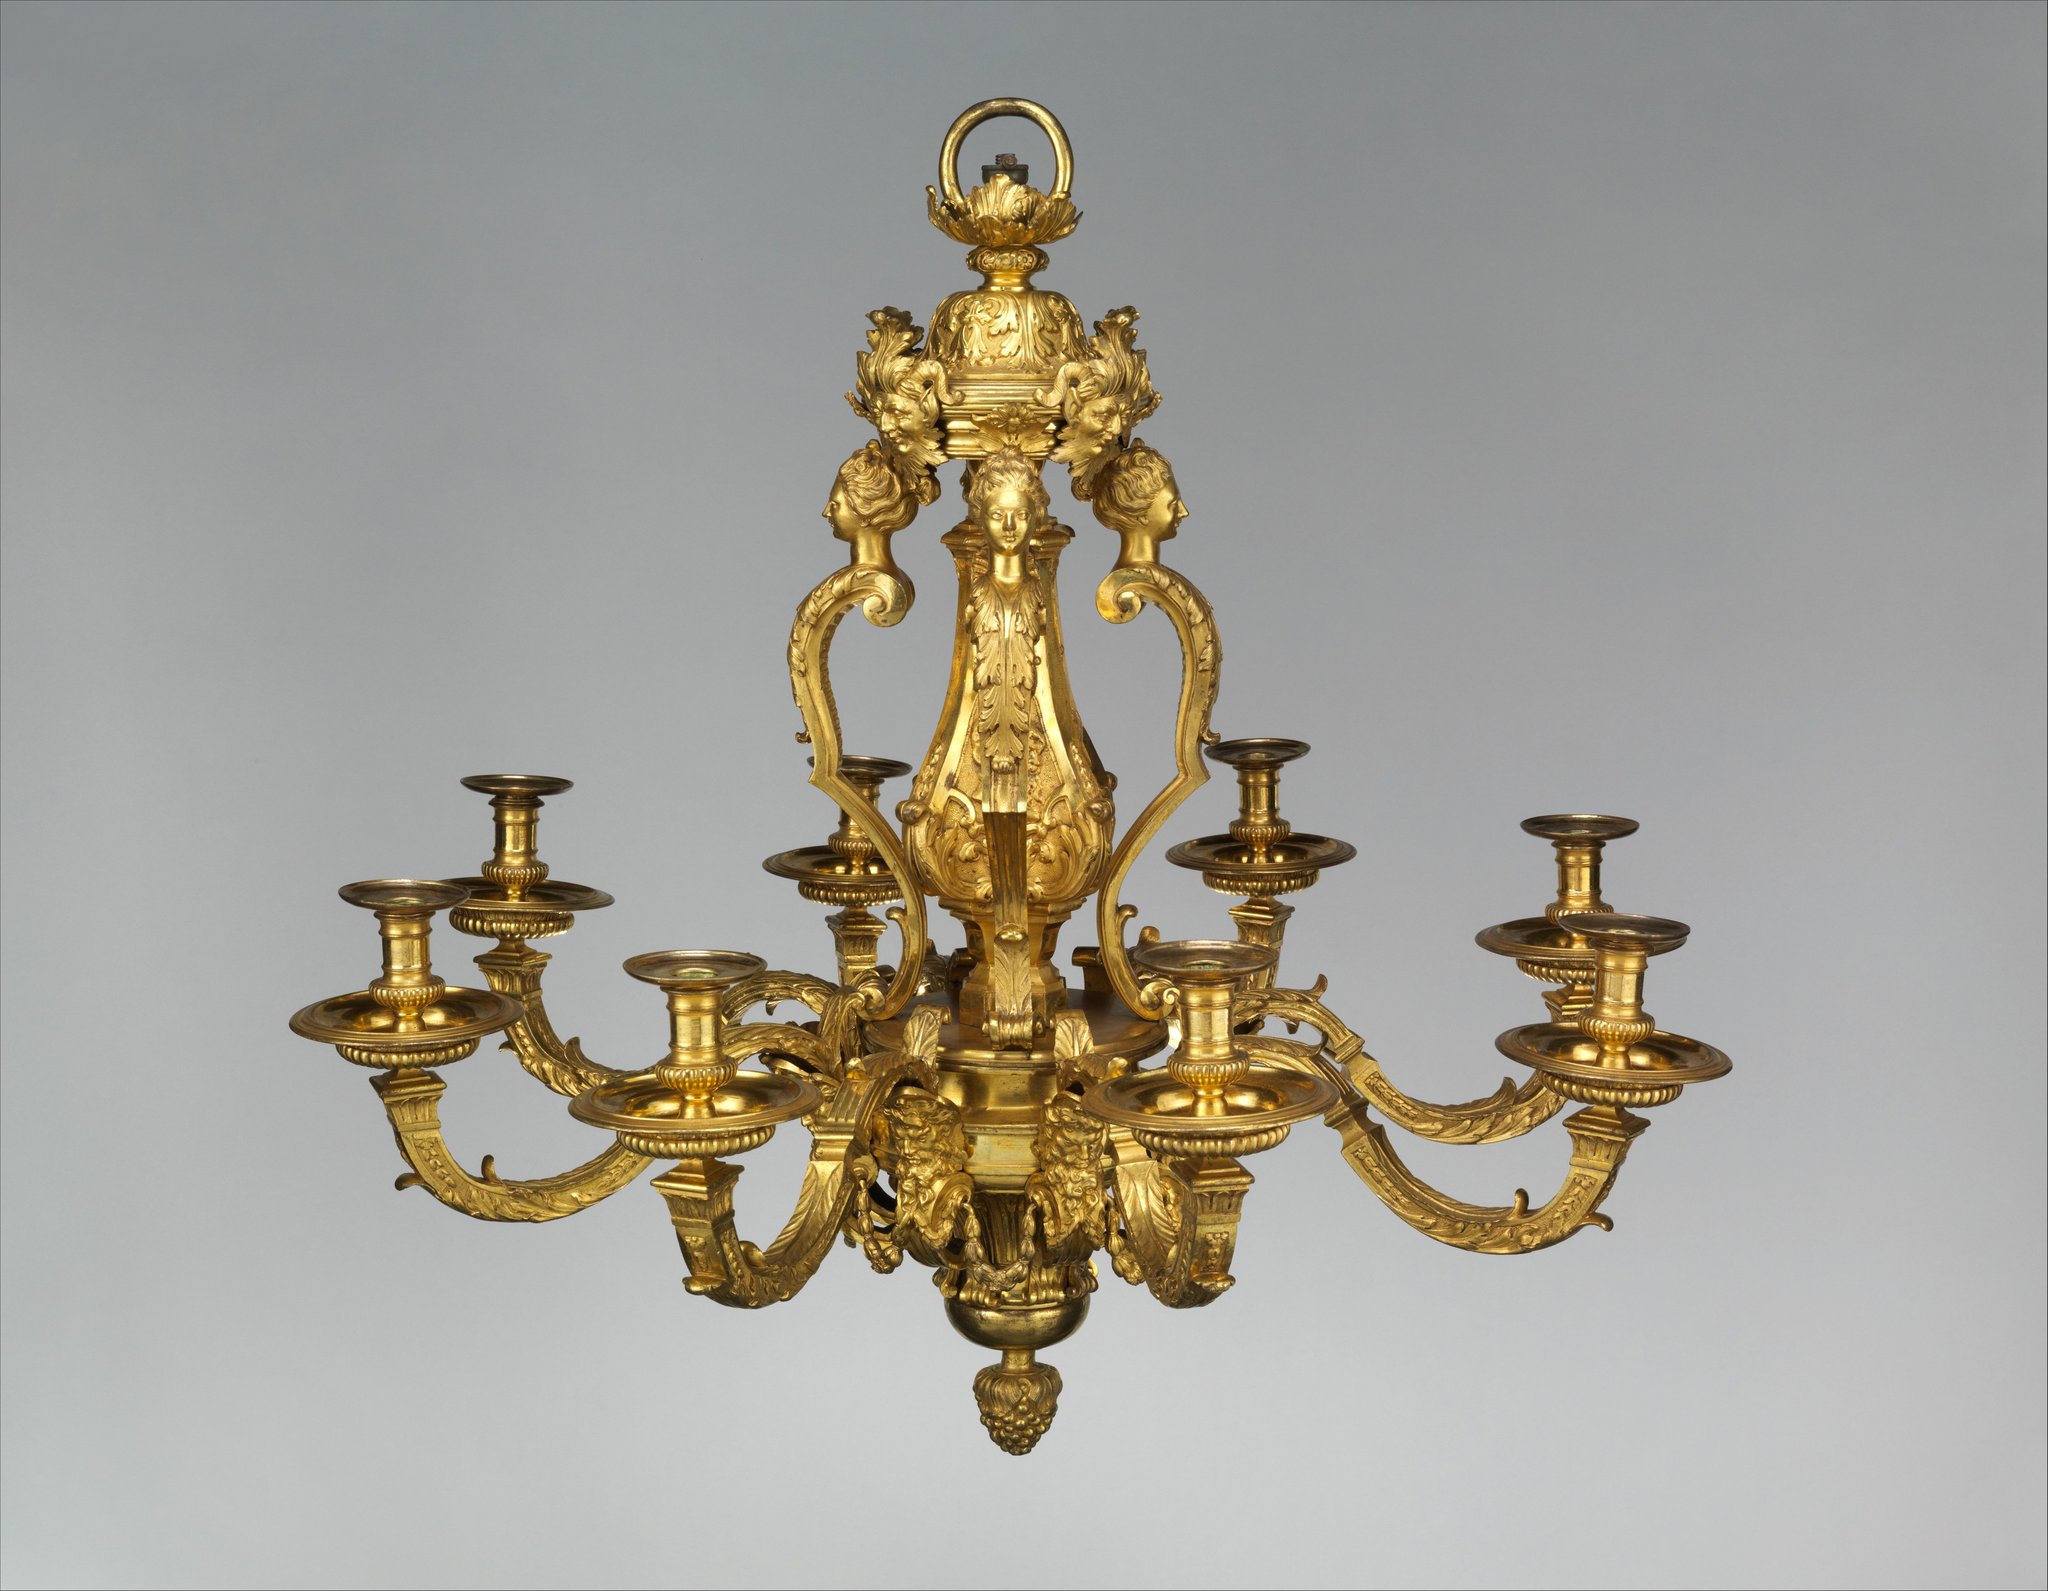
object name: chandelier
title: Eight-light chandelier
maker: andré charles boulle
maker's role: maker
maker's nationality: french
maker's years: 1642-1732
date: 1710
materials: bronze, gilt, iron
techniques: chasing